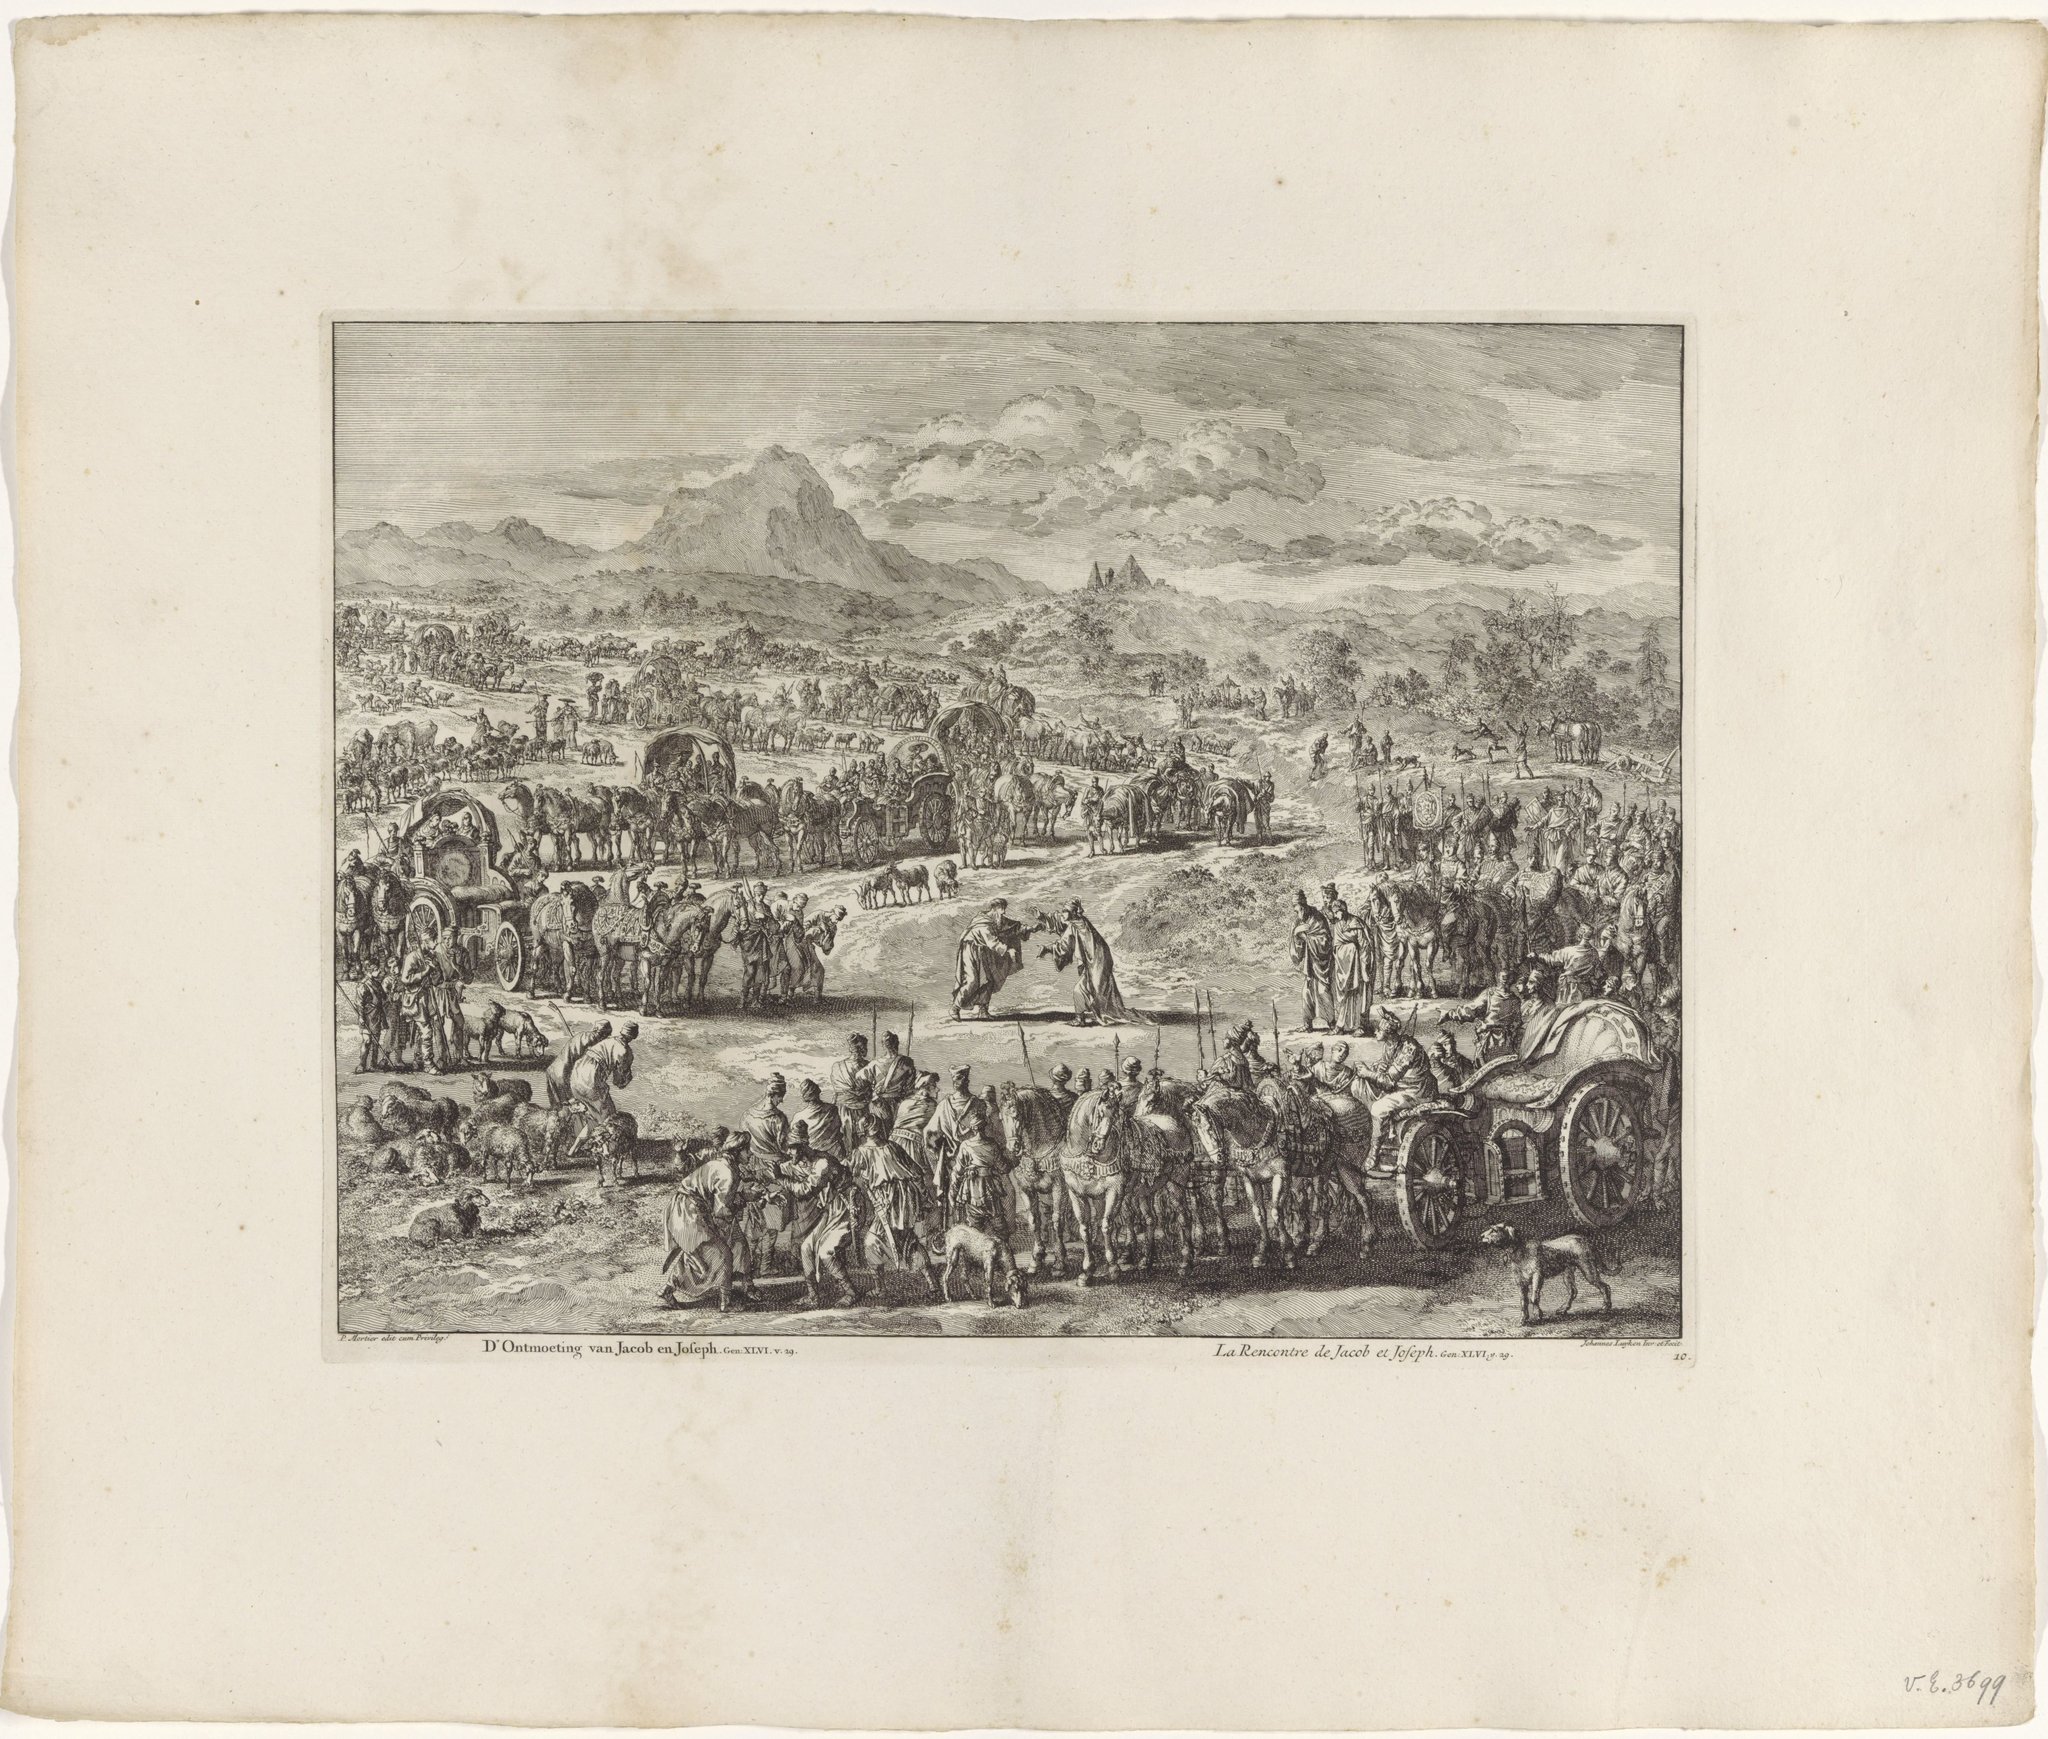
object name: book illustration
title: Ontmoeting van Jakob en Jozef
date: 1708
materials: paper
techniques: etching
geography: amsterdam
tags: the meeting of jacob and joseph in goshen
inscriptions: collector's mark: Lugt 2228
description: Illustratie voor: Icones Biblicae Veteris et Novi Testamenti, Amsterdam: Pieter Mortier, 1708.